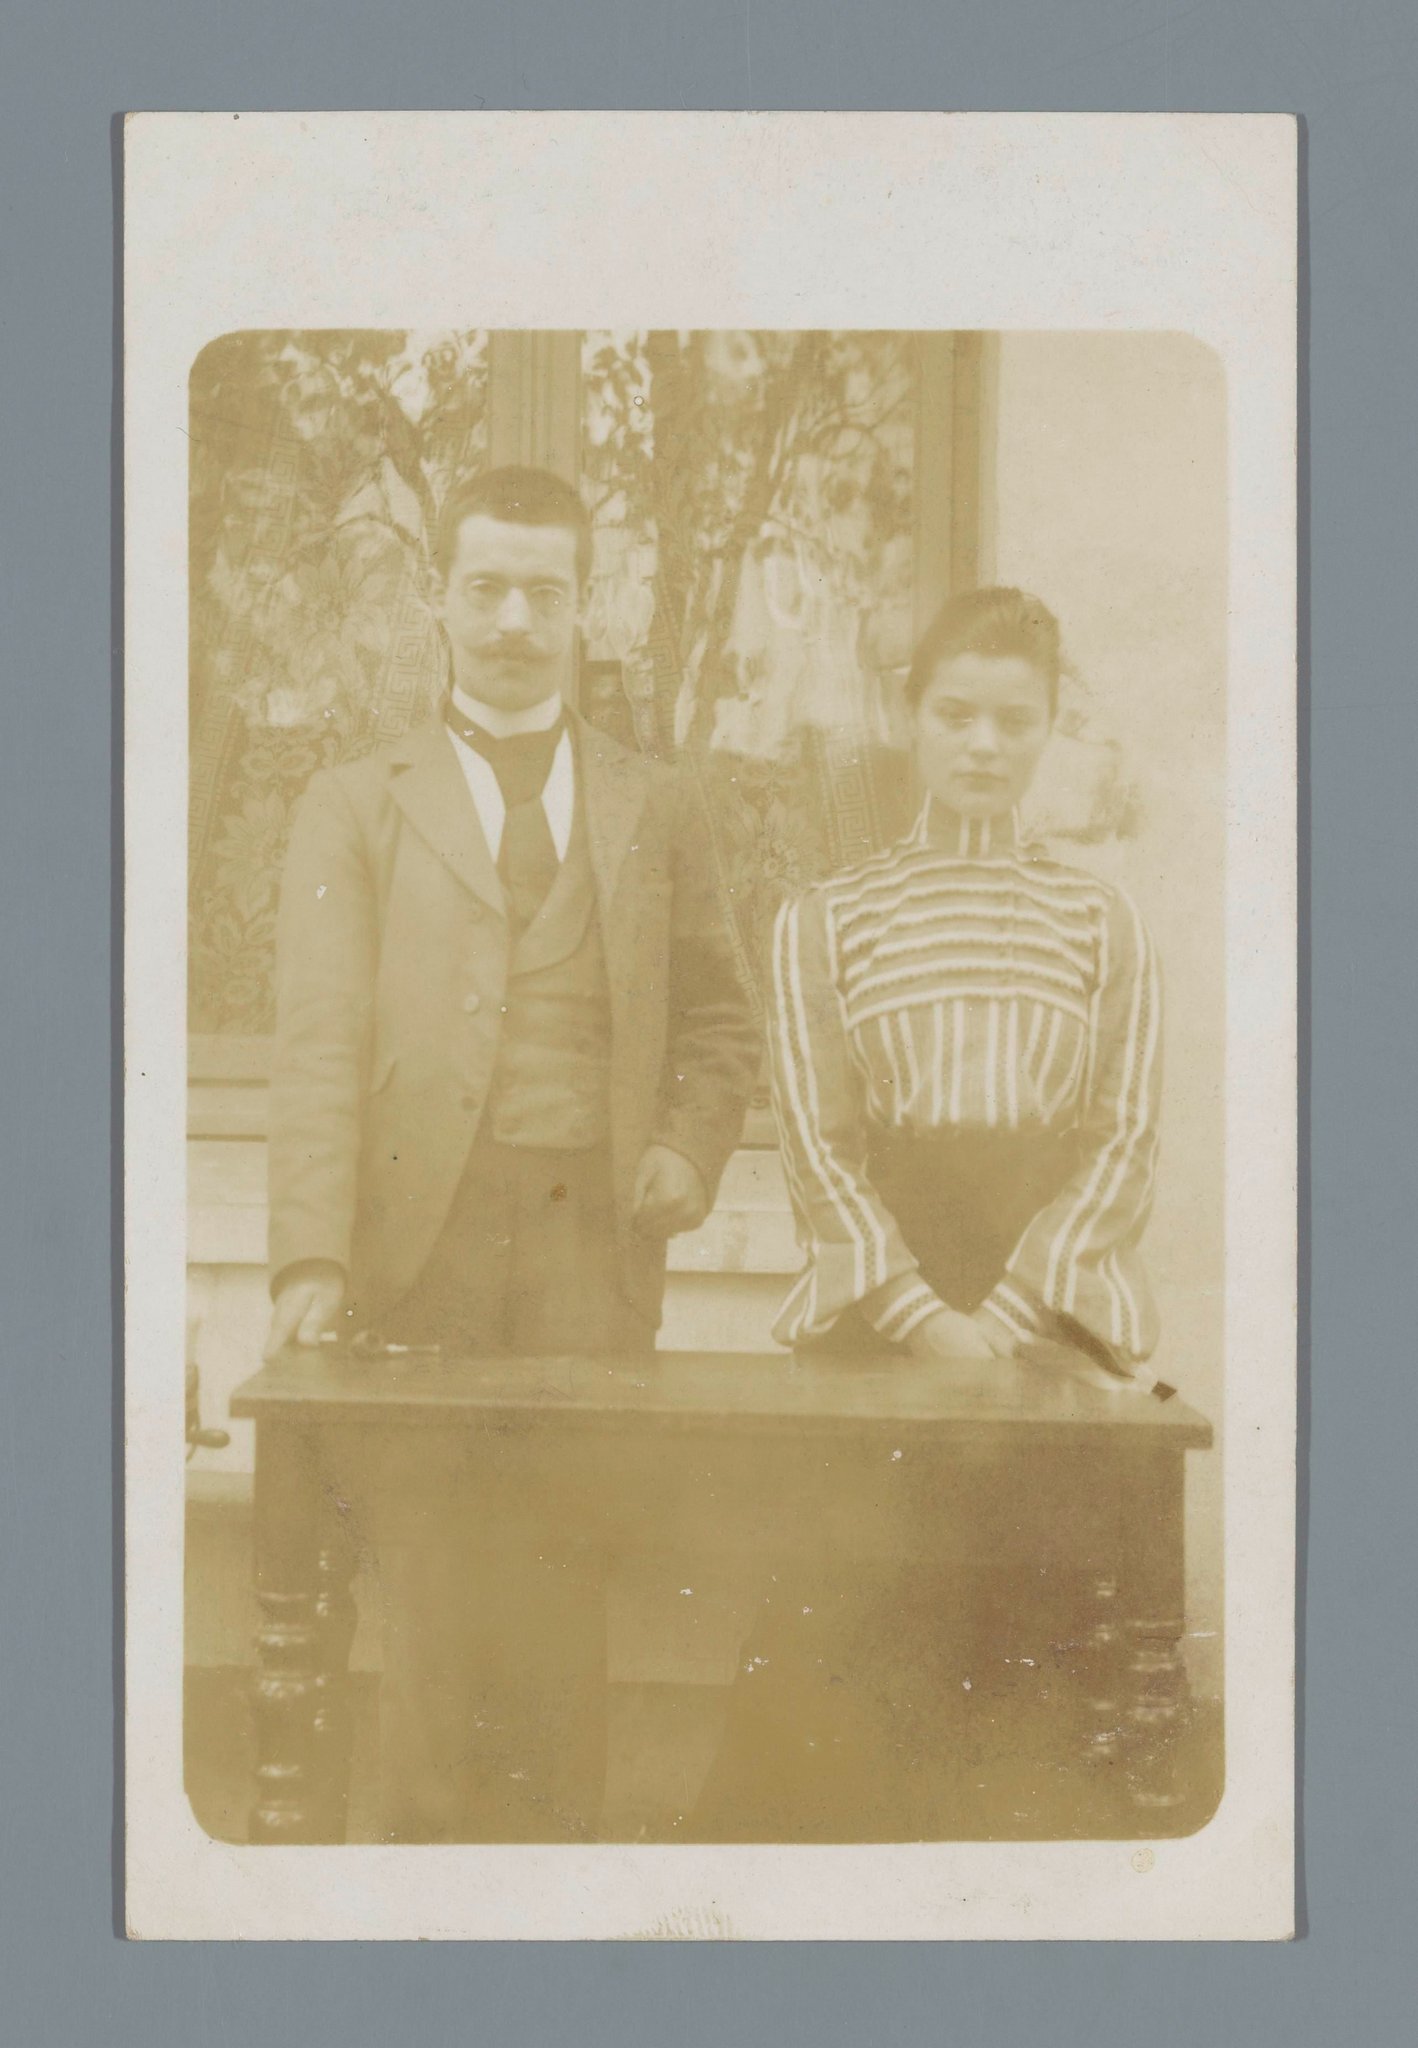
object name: ansichtkaart, prentbriefkaart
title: Portret van een onbekende man en vrouw achter een tafel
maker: Anonymous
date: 1900-1907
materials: photographic support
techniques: gelatin silver print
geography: germany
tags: adult woman, adult man, table